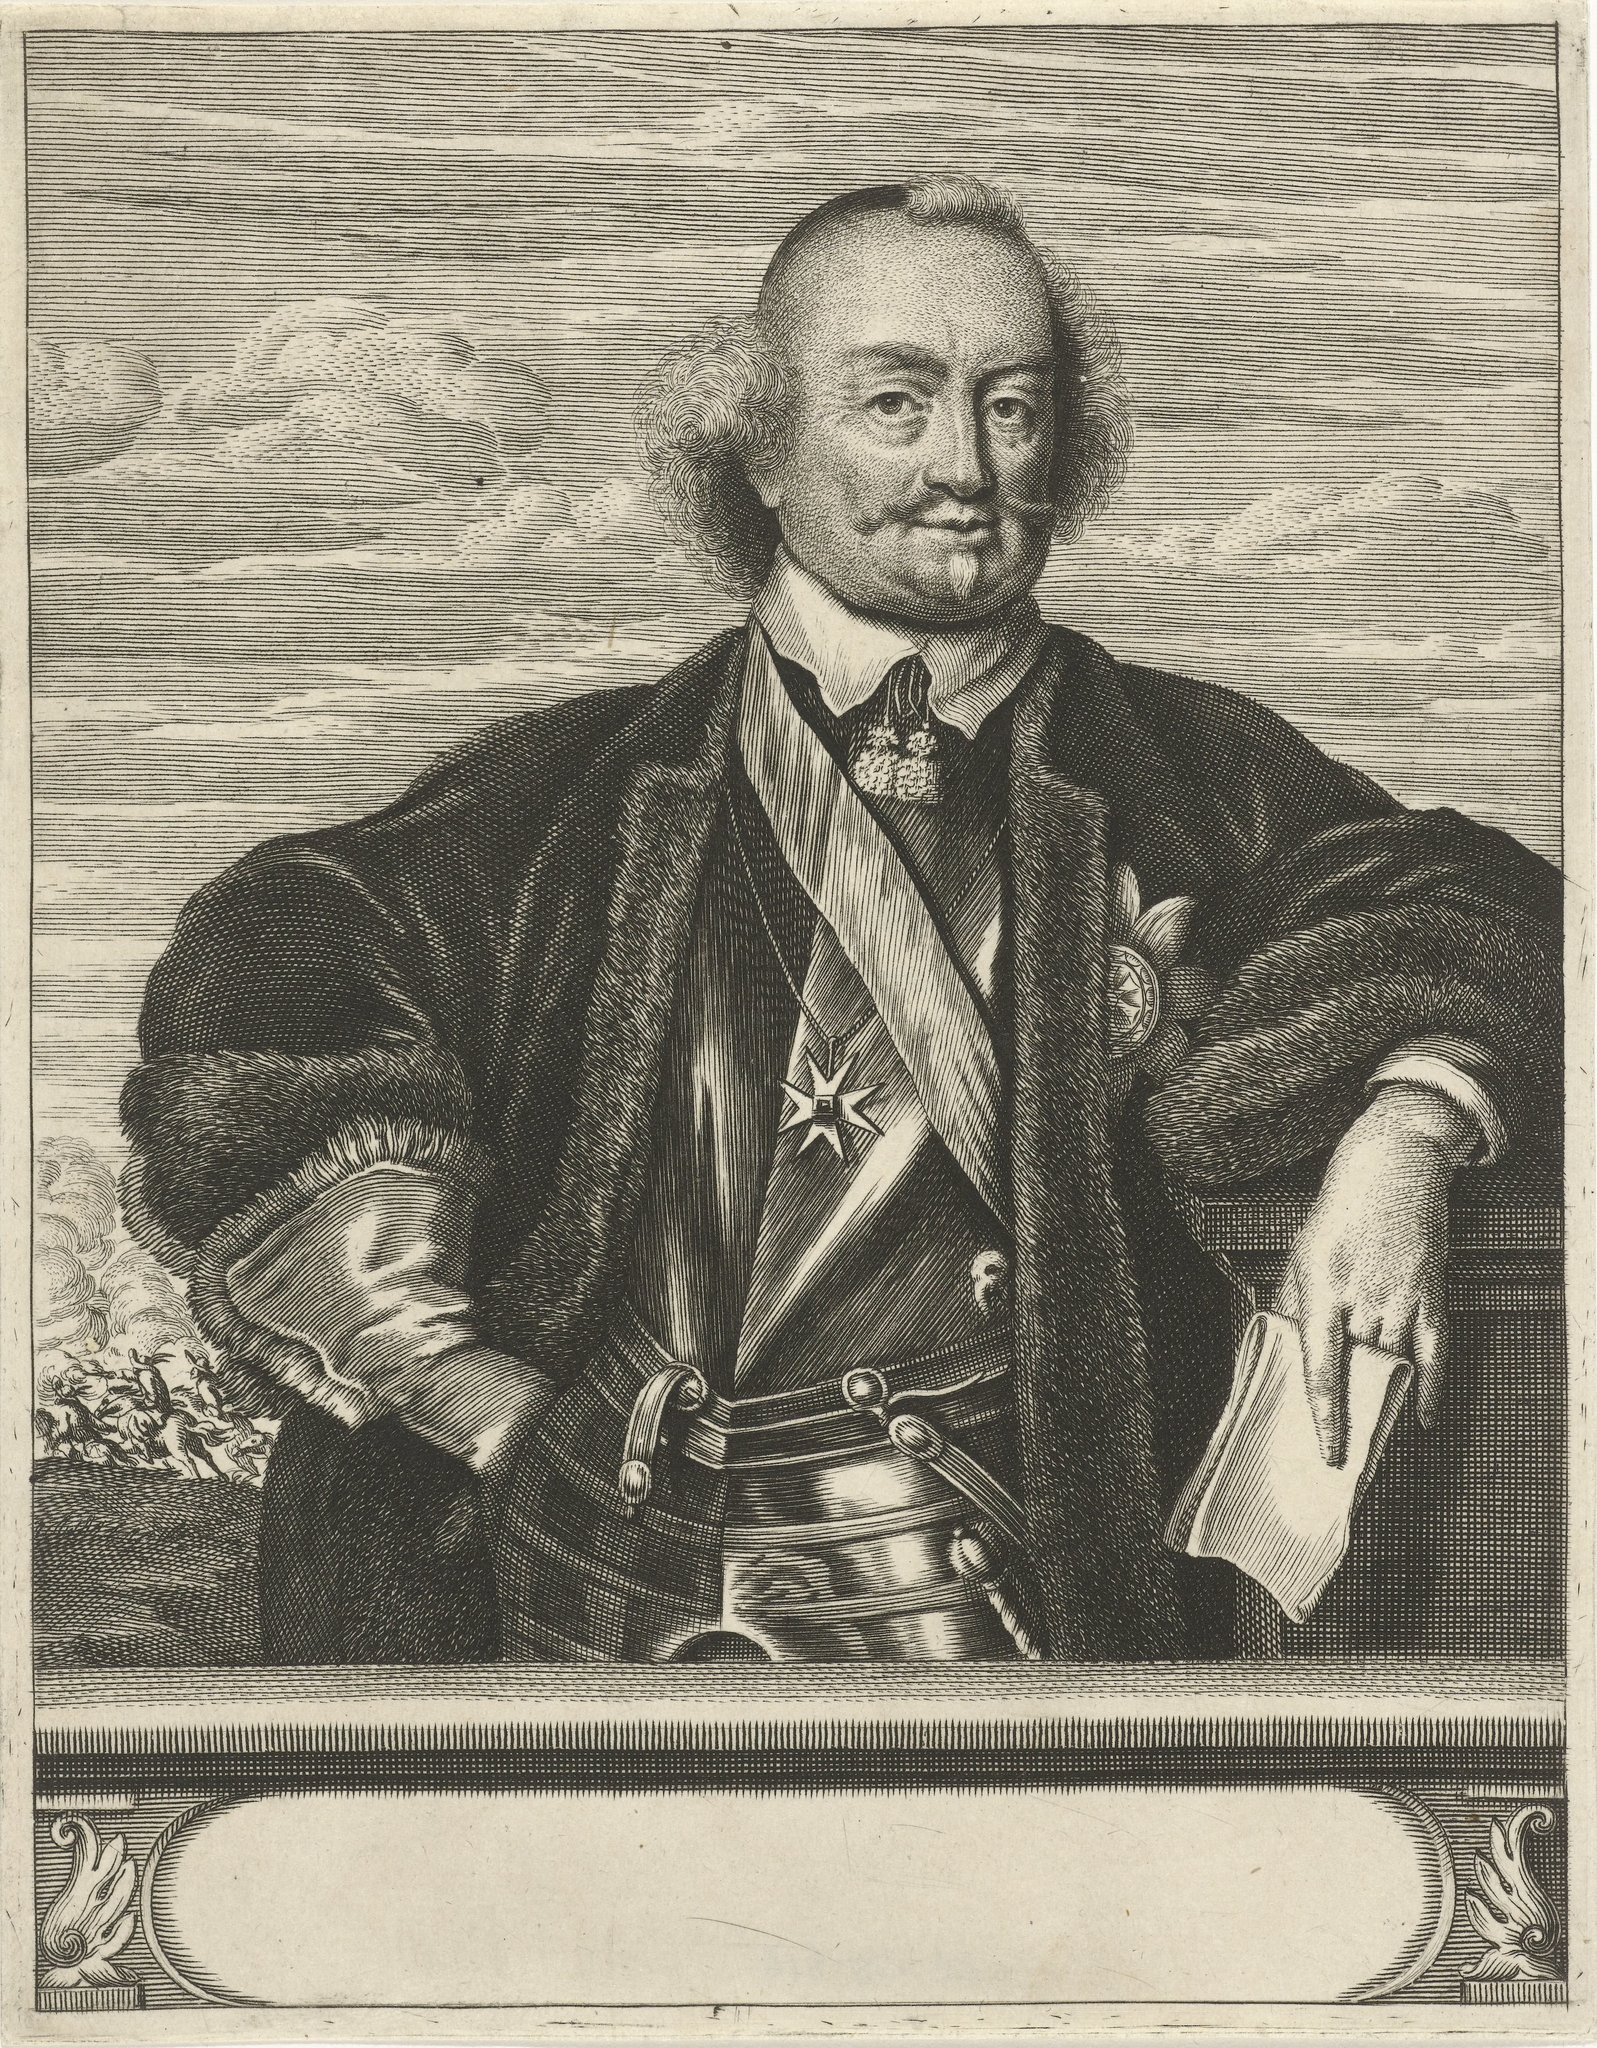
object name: print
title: Portret van Johan Maurits, graaf van Nassau-Siegen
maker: christiaan hagen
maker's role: draughtsman, print maker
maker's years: 1635-1707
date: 1663-1695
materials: paper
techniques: engraving, etching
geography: amsterdam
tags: earl, johan maurits graaf van nassau-siegen, armour, battle, fashion, clothing (+ fur used for clothes), paper (writing material)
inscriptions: collector's mark: Lugt 2228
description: Portret ten halven lijve van Johan Maurits, graaf van Nassau-Siegen. Hij draagt een harnas, met daarover een mantel gevoerd met bont. Hij leunt met zijn linkerarm op een zuil en houdt een brief in zijn hand. Om zijn hals een ketting met een Maltezer kruis. Op de achtergrond is een veldslag afgebeeld. Onder zijn portret een plint met een leeg cartouche.